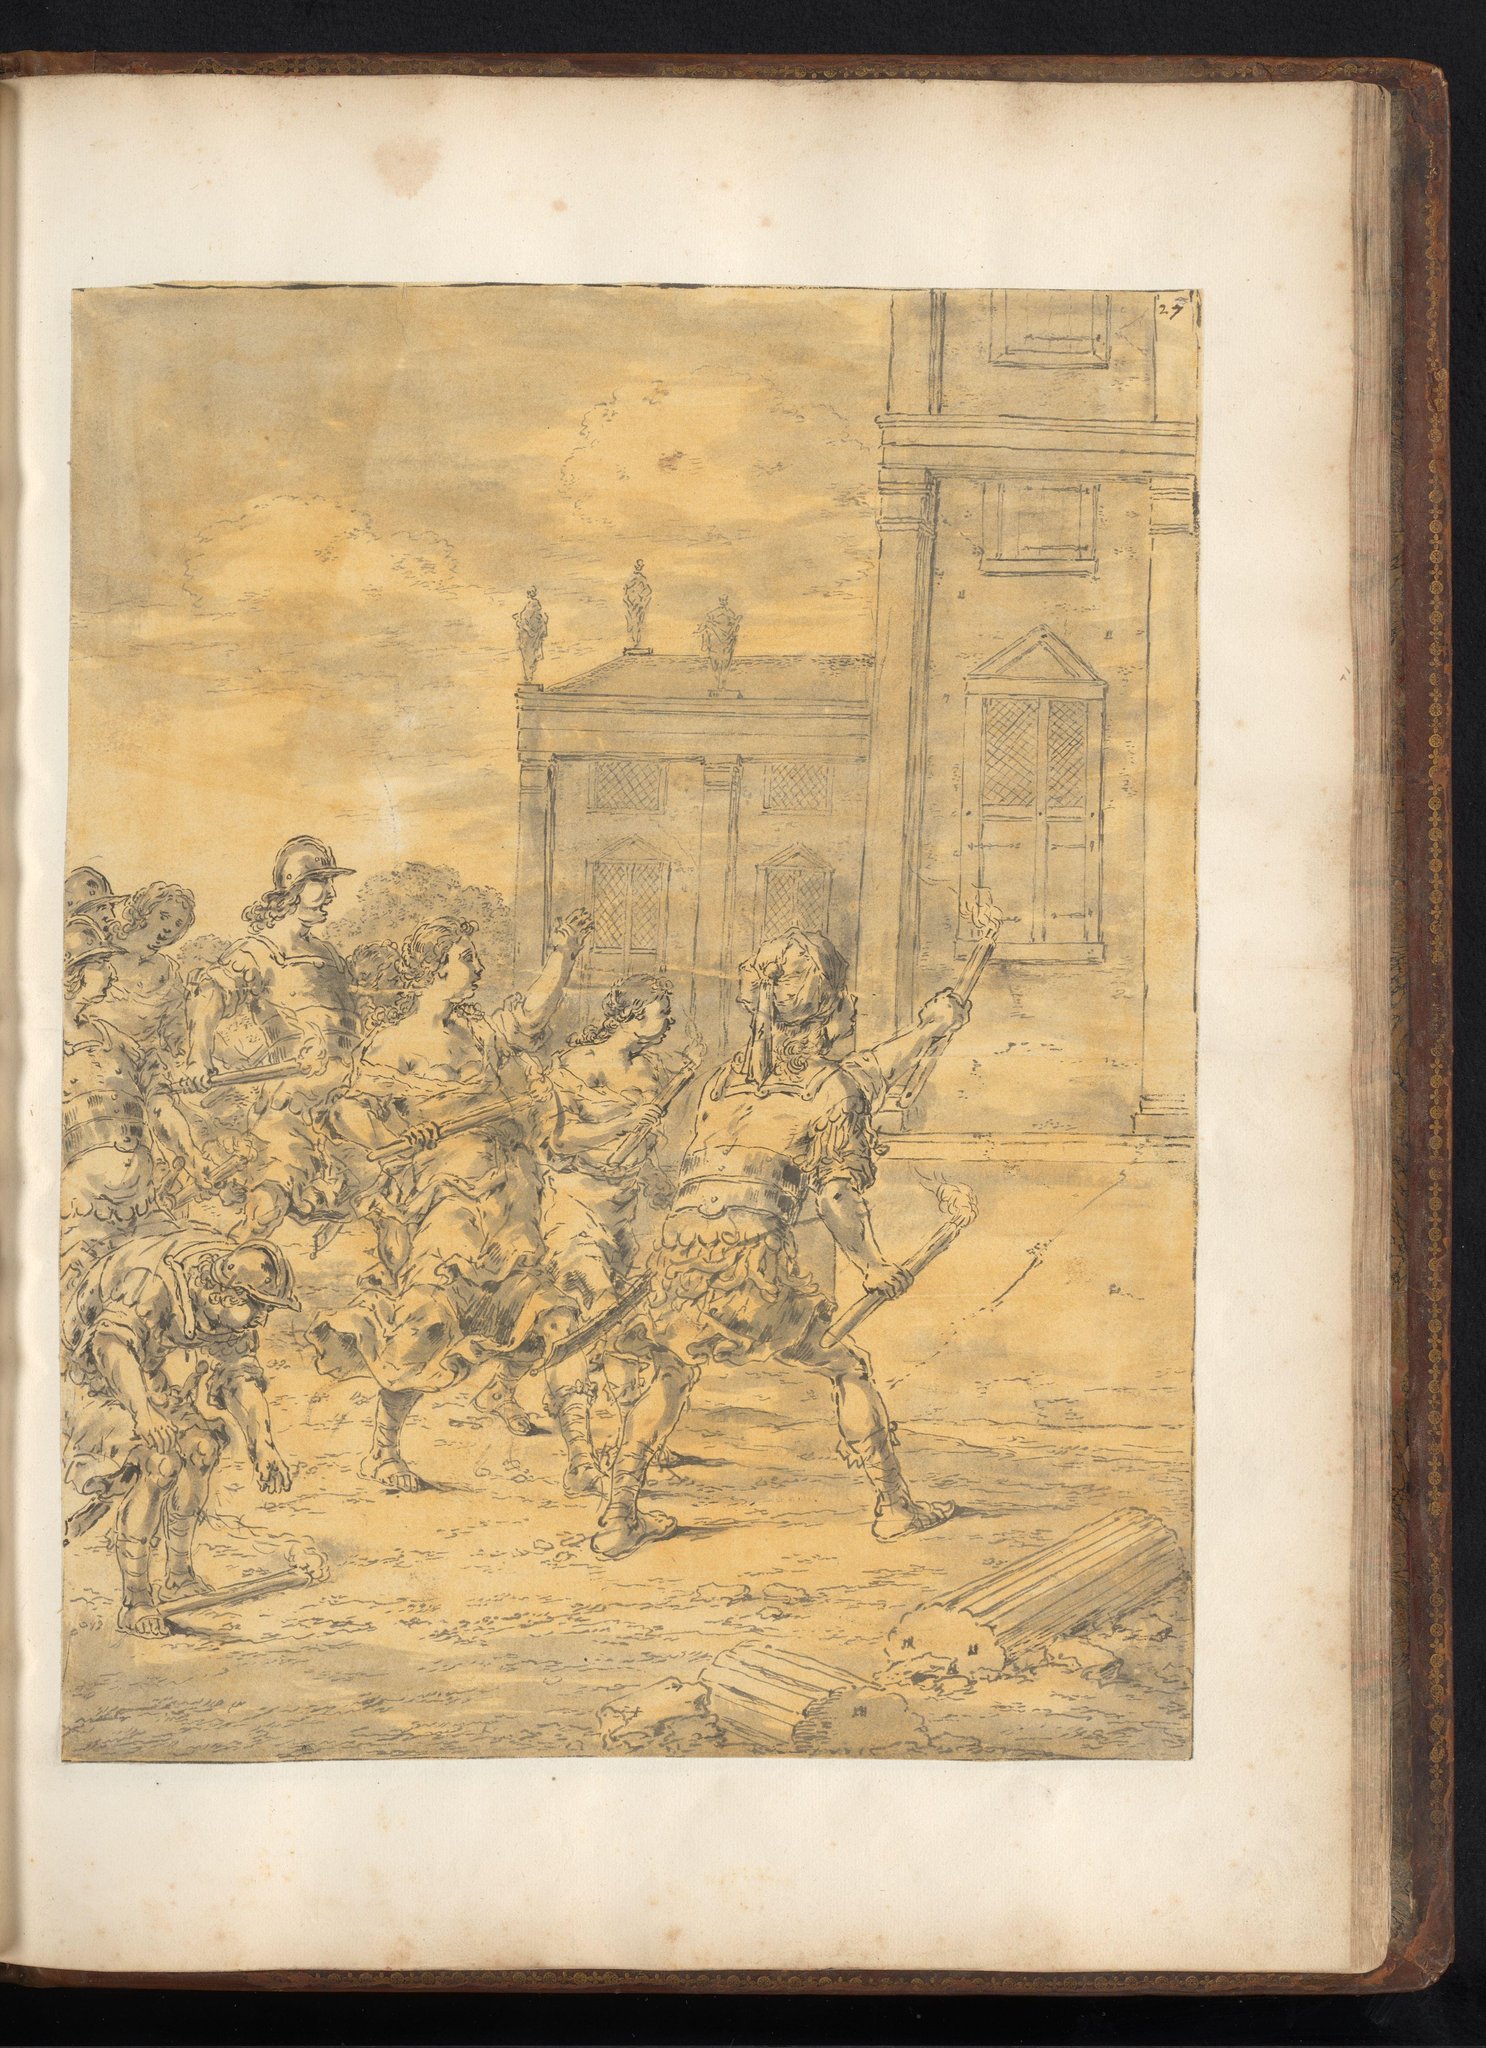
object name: album leaf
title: Alexander verbrant het konincklick paleis van Darius, met een toorts in de handt, de hoere Thais op gelijcke manier hem volgende, en alle sijn hovelinge en concubijne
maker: leonaert bramer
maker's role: draughtsman, painter, print maker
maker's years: 1596-1674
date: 1655-1665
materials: ink, paper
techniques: brush, pen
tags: in a fit of intoxication at a feast, and encouraged by the courtesan thais, alexander sets persepolis on fire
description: Alexander der Grote, gevolgd door de hetaere Thaïs en enkele hovelingen en vrouwen, steekt het paleis van Xerxes te Persepolis in de brand. Volgens het bijschrift steekt Alexander het paleis van Darius in de brand, maar dit komt niet overeen met de bronnen. Rechtsboven genummerd: 27. Tekening maakt deel uit van een album.